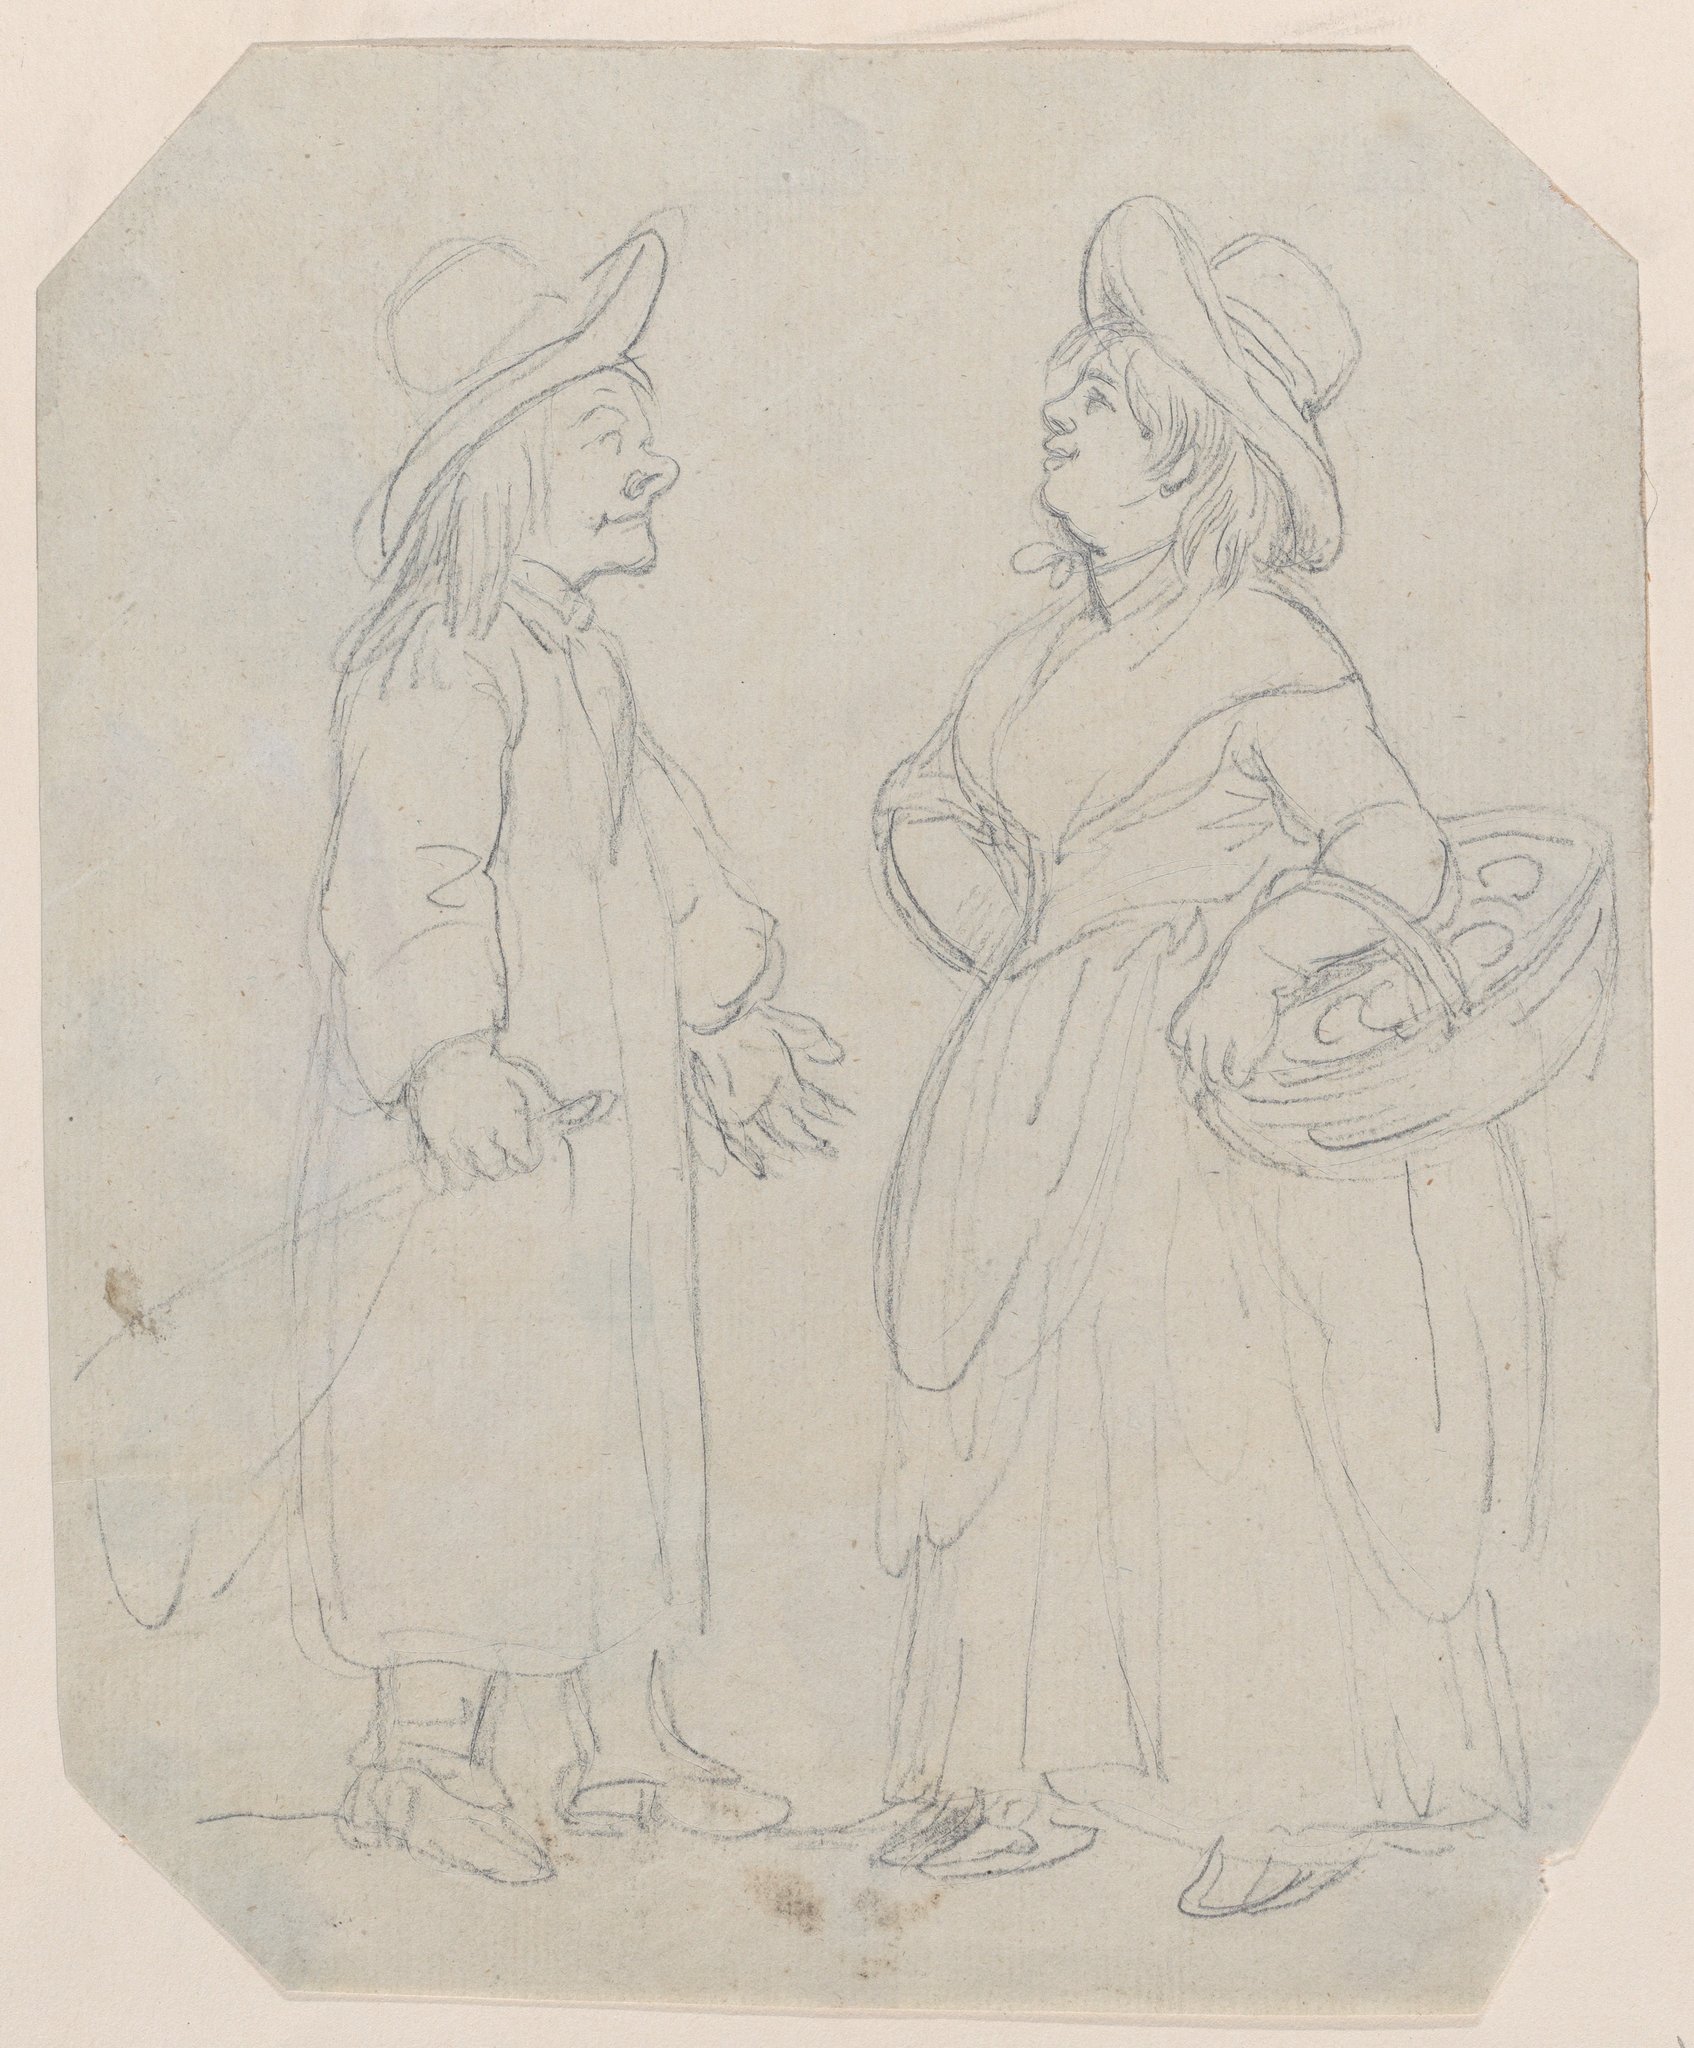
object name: drawing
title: Country Lovers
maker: george murgatroyd woodward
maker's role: artist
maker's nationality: british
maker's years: 1765-1809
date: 1798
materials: graphite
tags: men,women